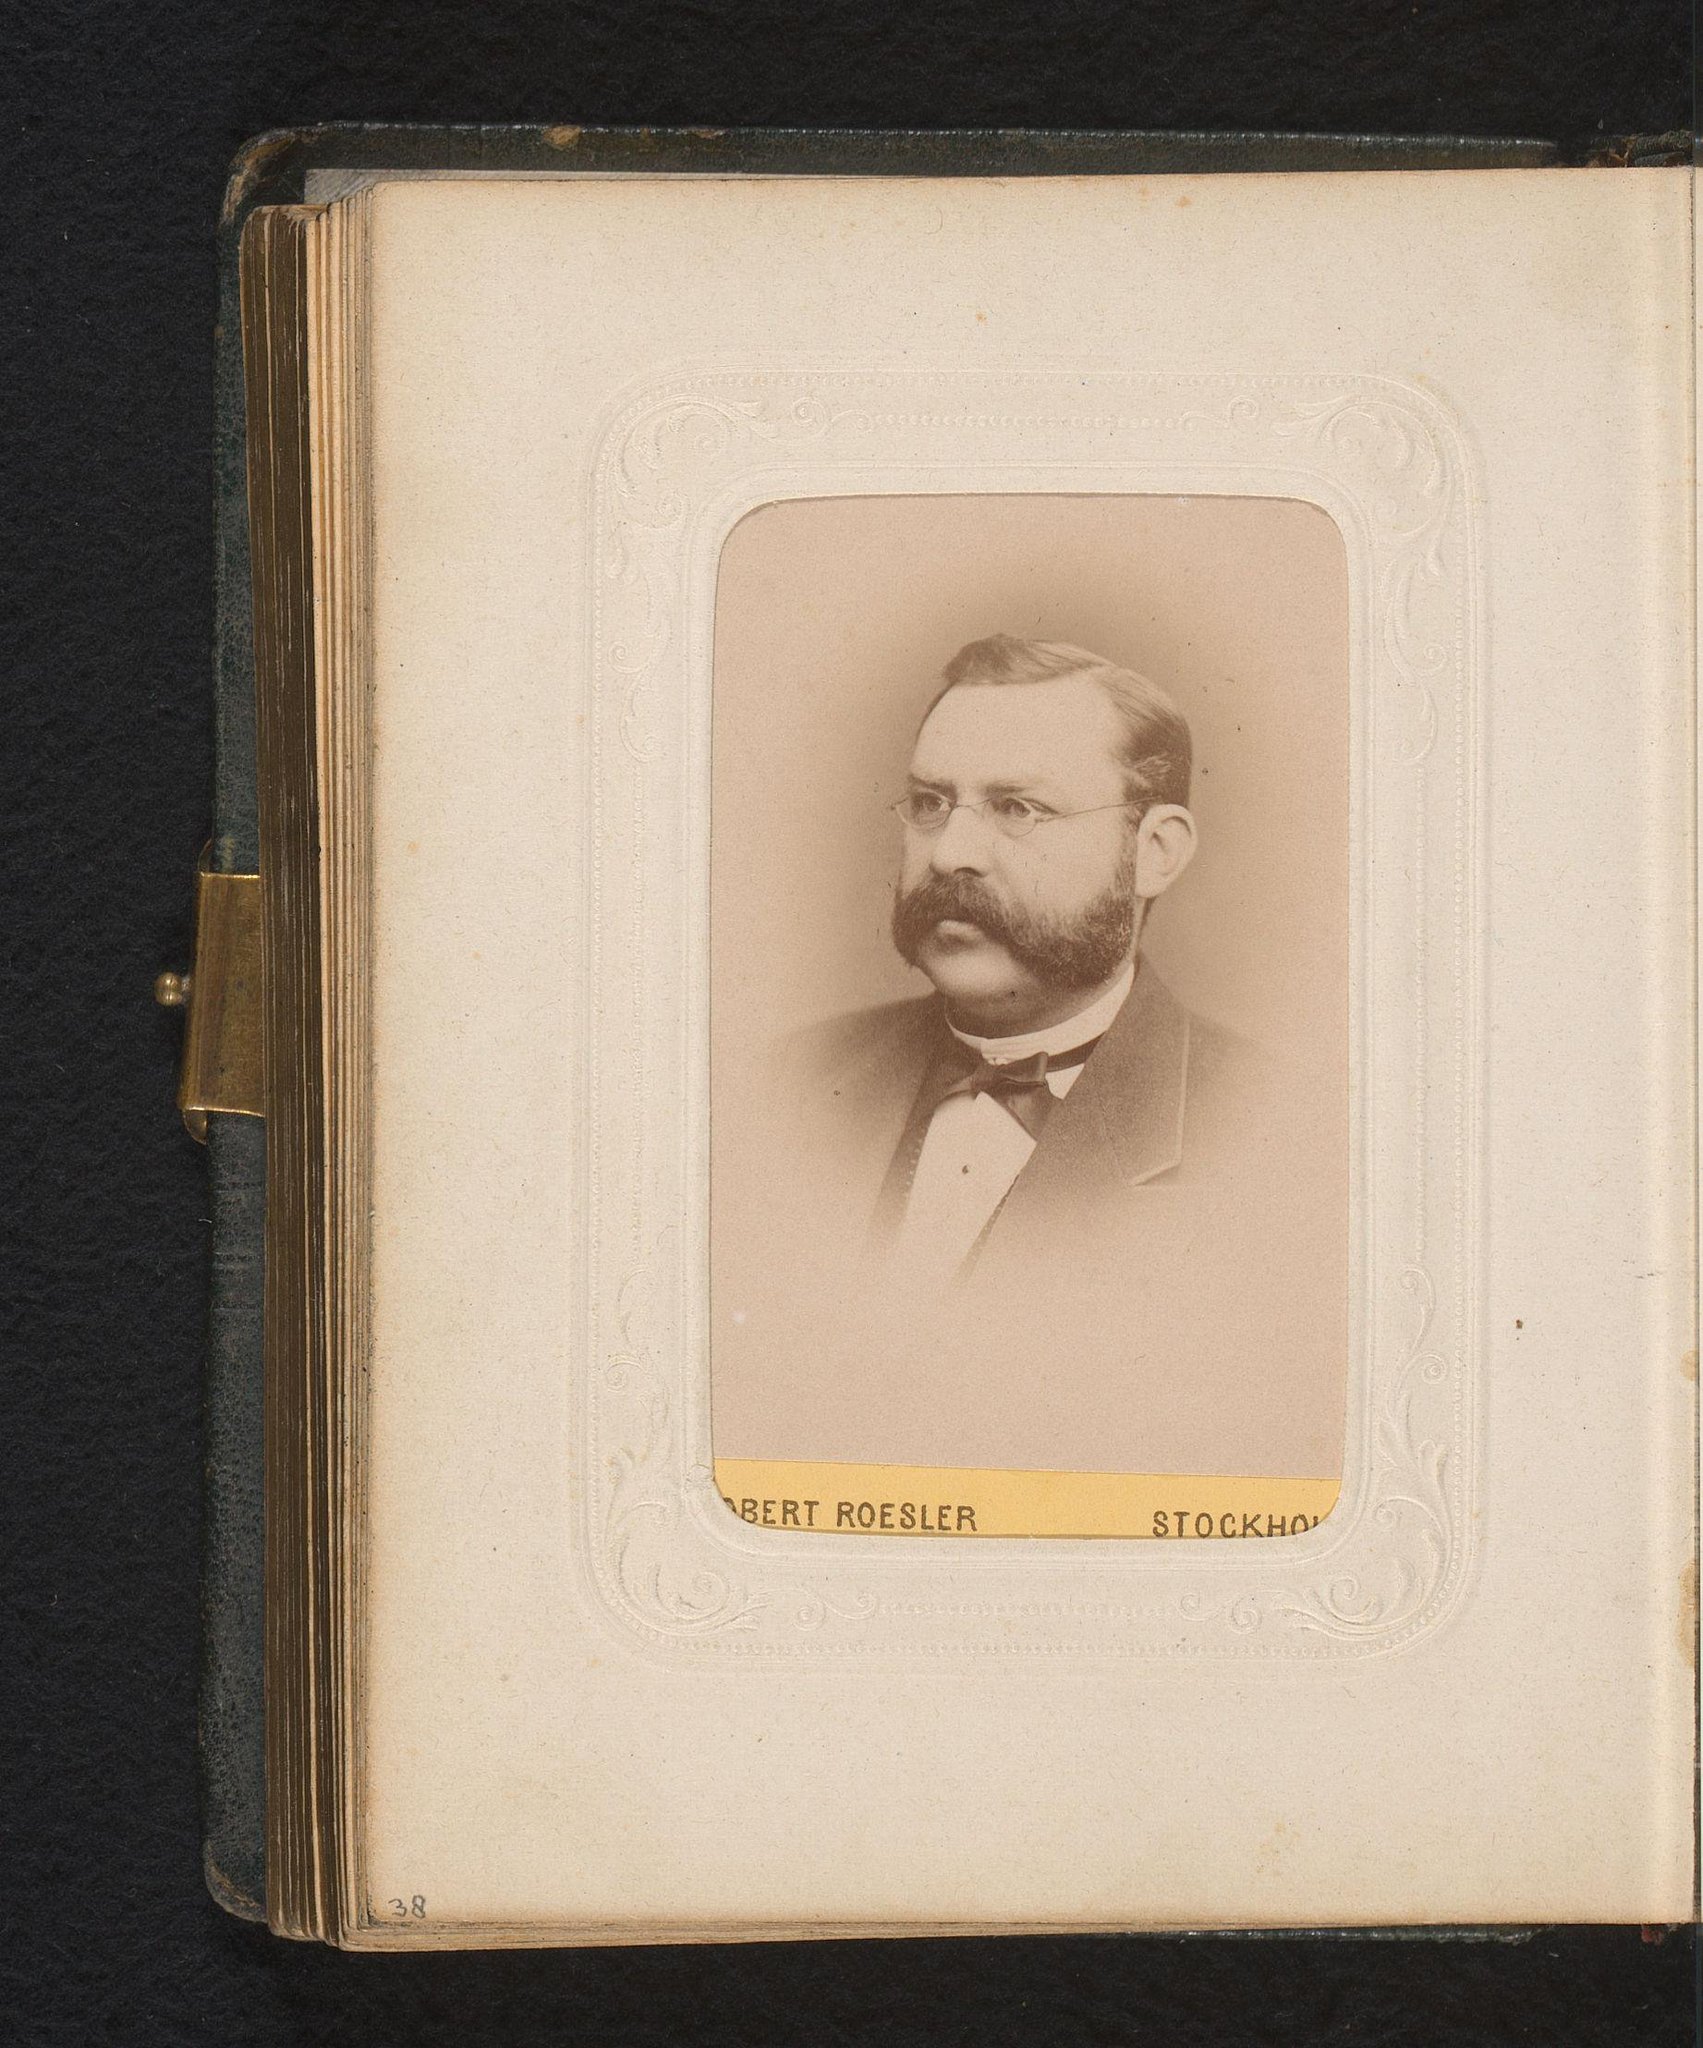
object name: carte de visite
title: Portret van een man met snor en bril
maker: august roesler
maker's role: fotograaf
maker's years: 1837-1896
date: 1860-1900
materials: cardboard, photographic support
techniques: albumen print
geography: stockholm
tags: eyeglasses, spectacles, moustache, historical persons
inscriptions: inscription: ‘Robert Roesler's/ Fotografi-Atelier/ STOCKHOLM/ 38, Stora Nygatan 38./ Pläten förvaras för efterbeställning.’